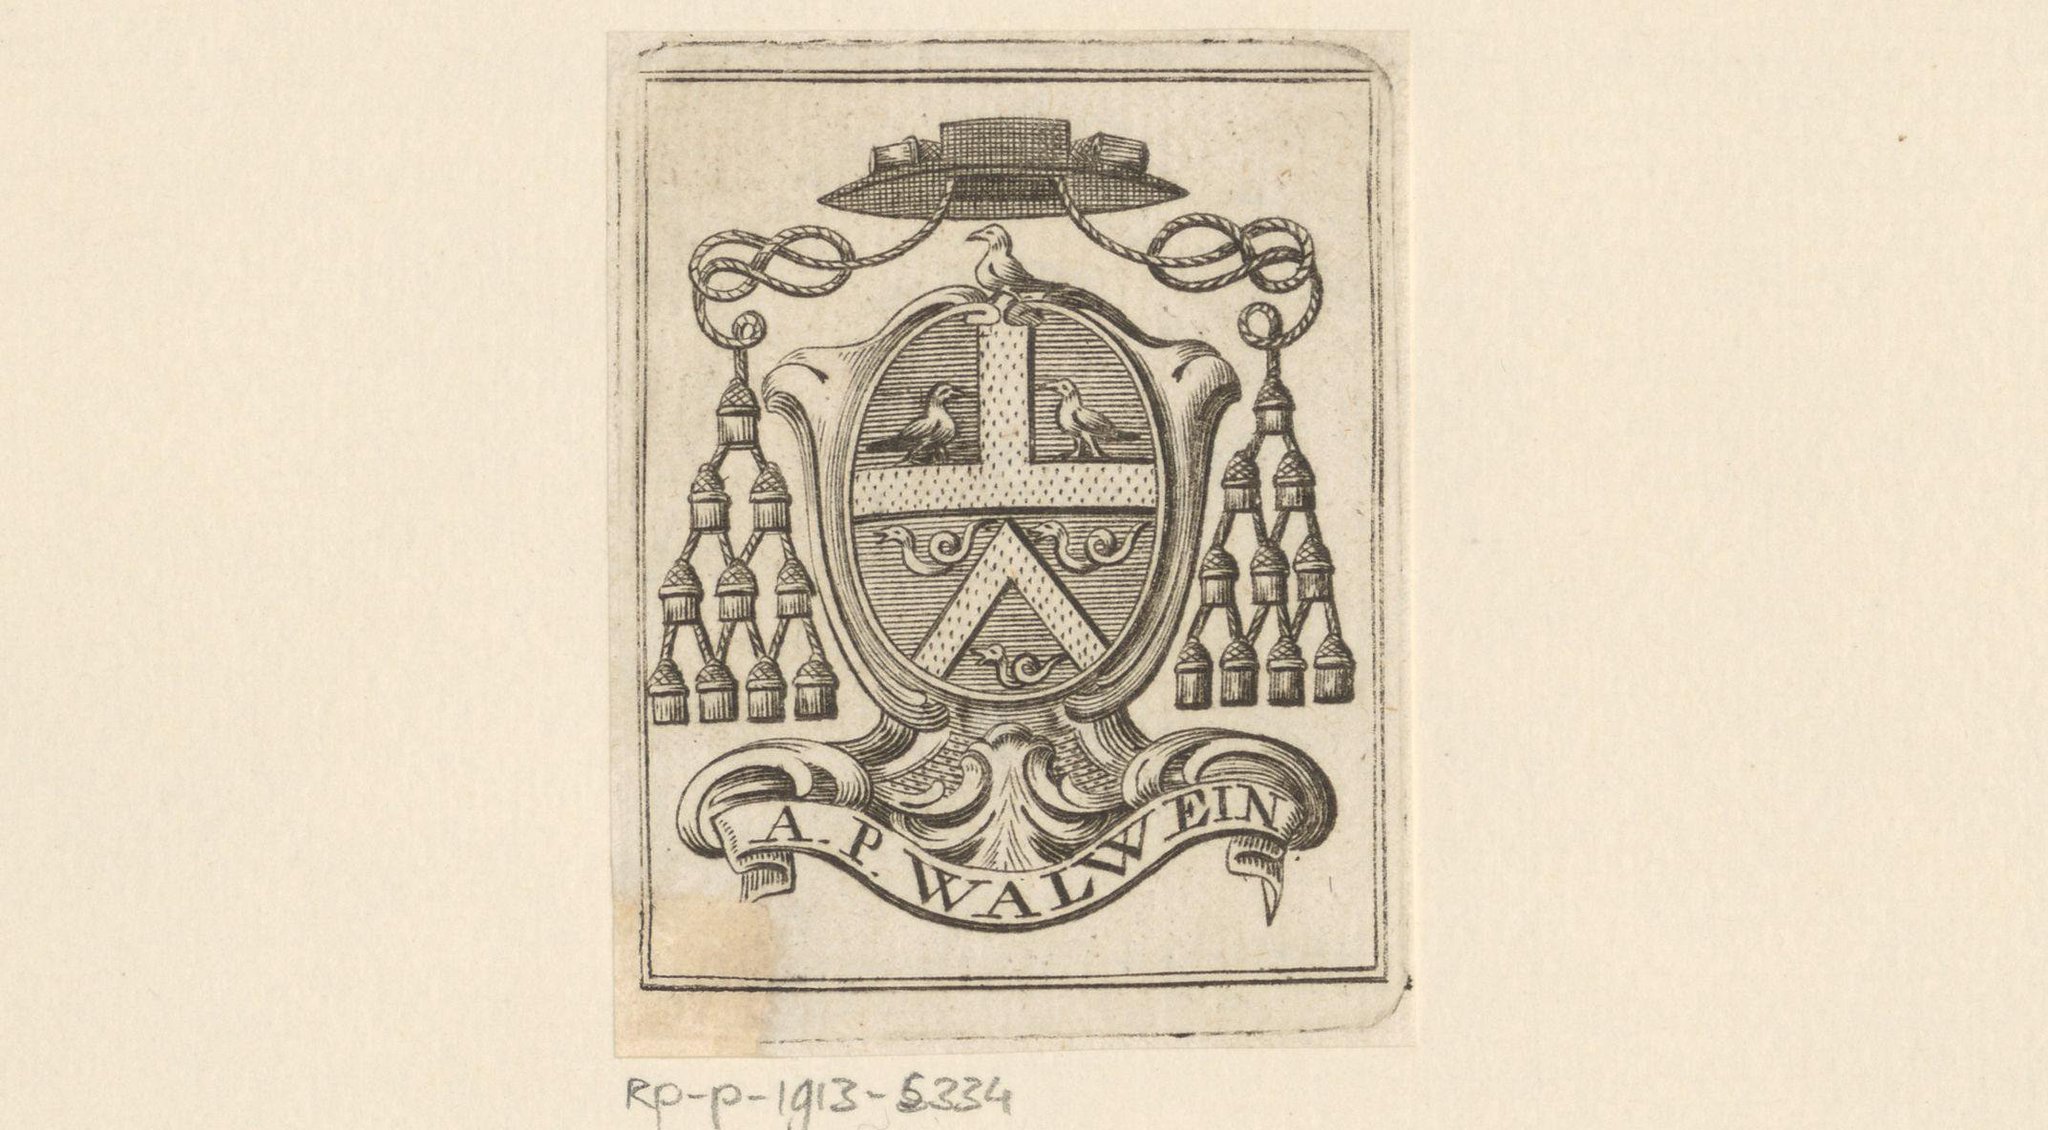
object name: bookplate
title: Ex libris van A.P. Walwein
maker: Anonymous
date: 1700-1799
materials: paper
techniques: engraving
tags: insignia of cardinal, e.g. hat, mantle, armorial bearing, heraldry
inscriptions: collector's mark: Lugt 2760, collector's mark: Lugt 2233